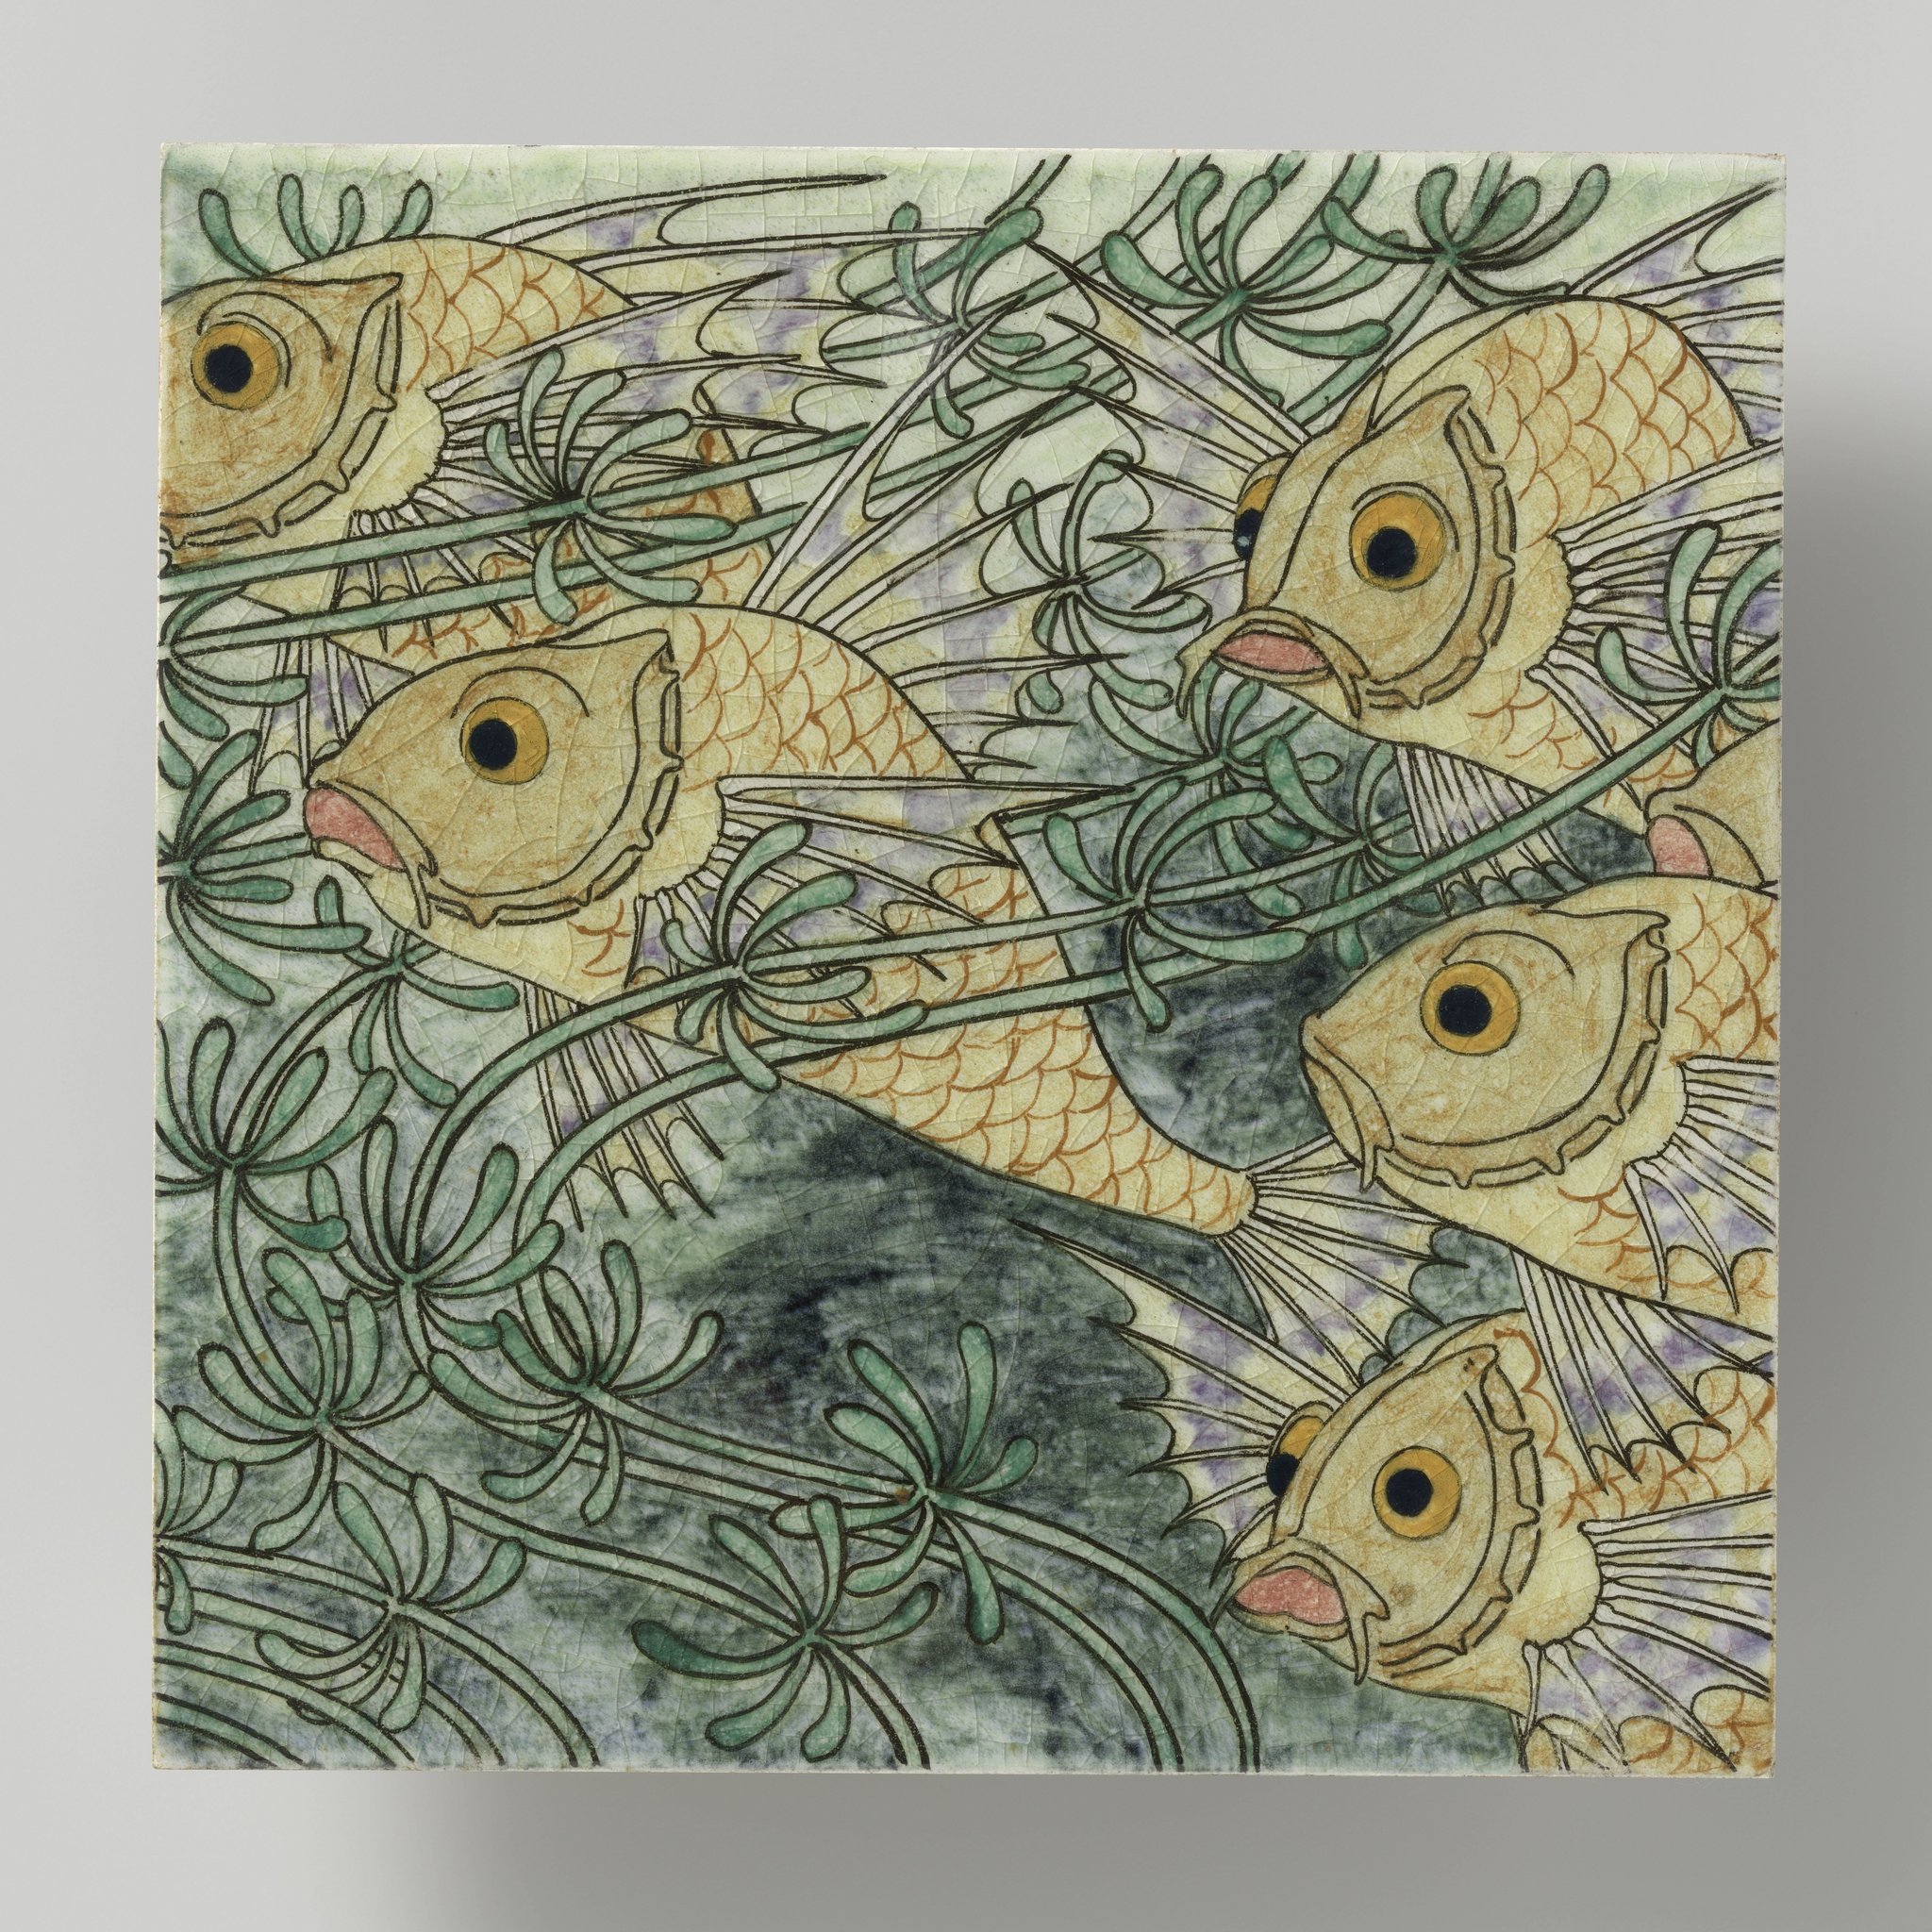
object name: tile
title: Tile painted with Fish and Weeds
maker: bert nienhuis (i)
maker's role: designer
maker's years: 1873-1960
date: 1896-1901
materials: earthenware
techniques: painted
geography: amsterdam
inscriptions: monogram: ‘LN’, mark: ‘Craven Dunhill & Co., Shropshire, England’